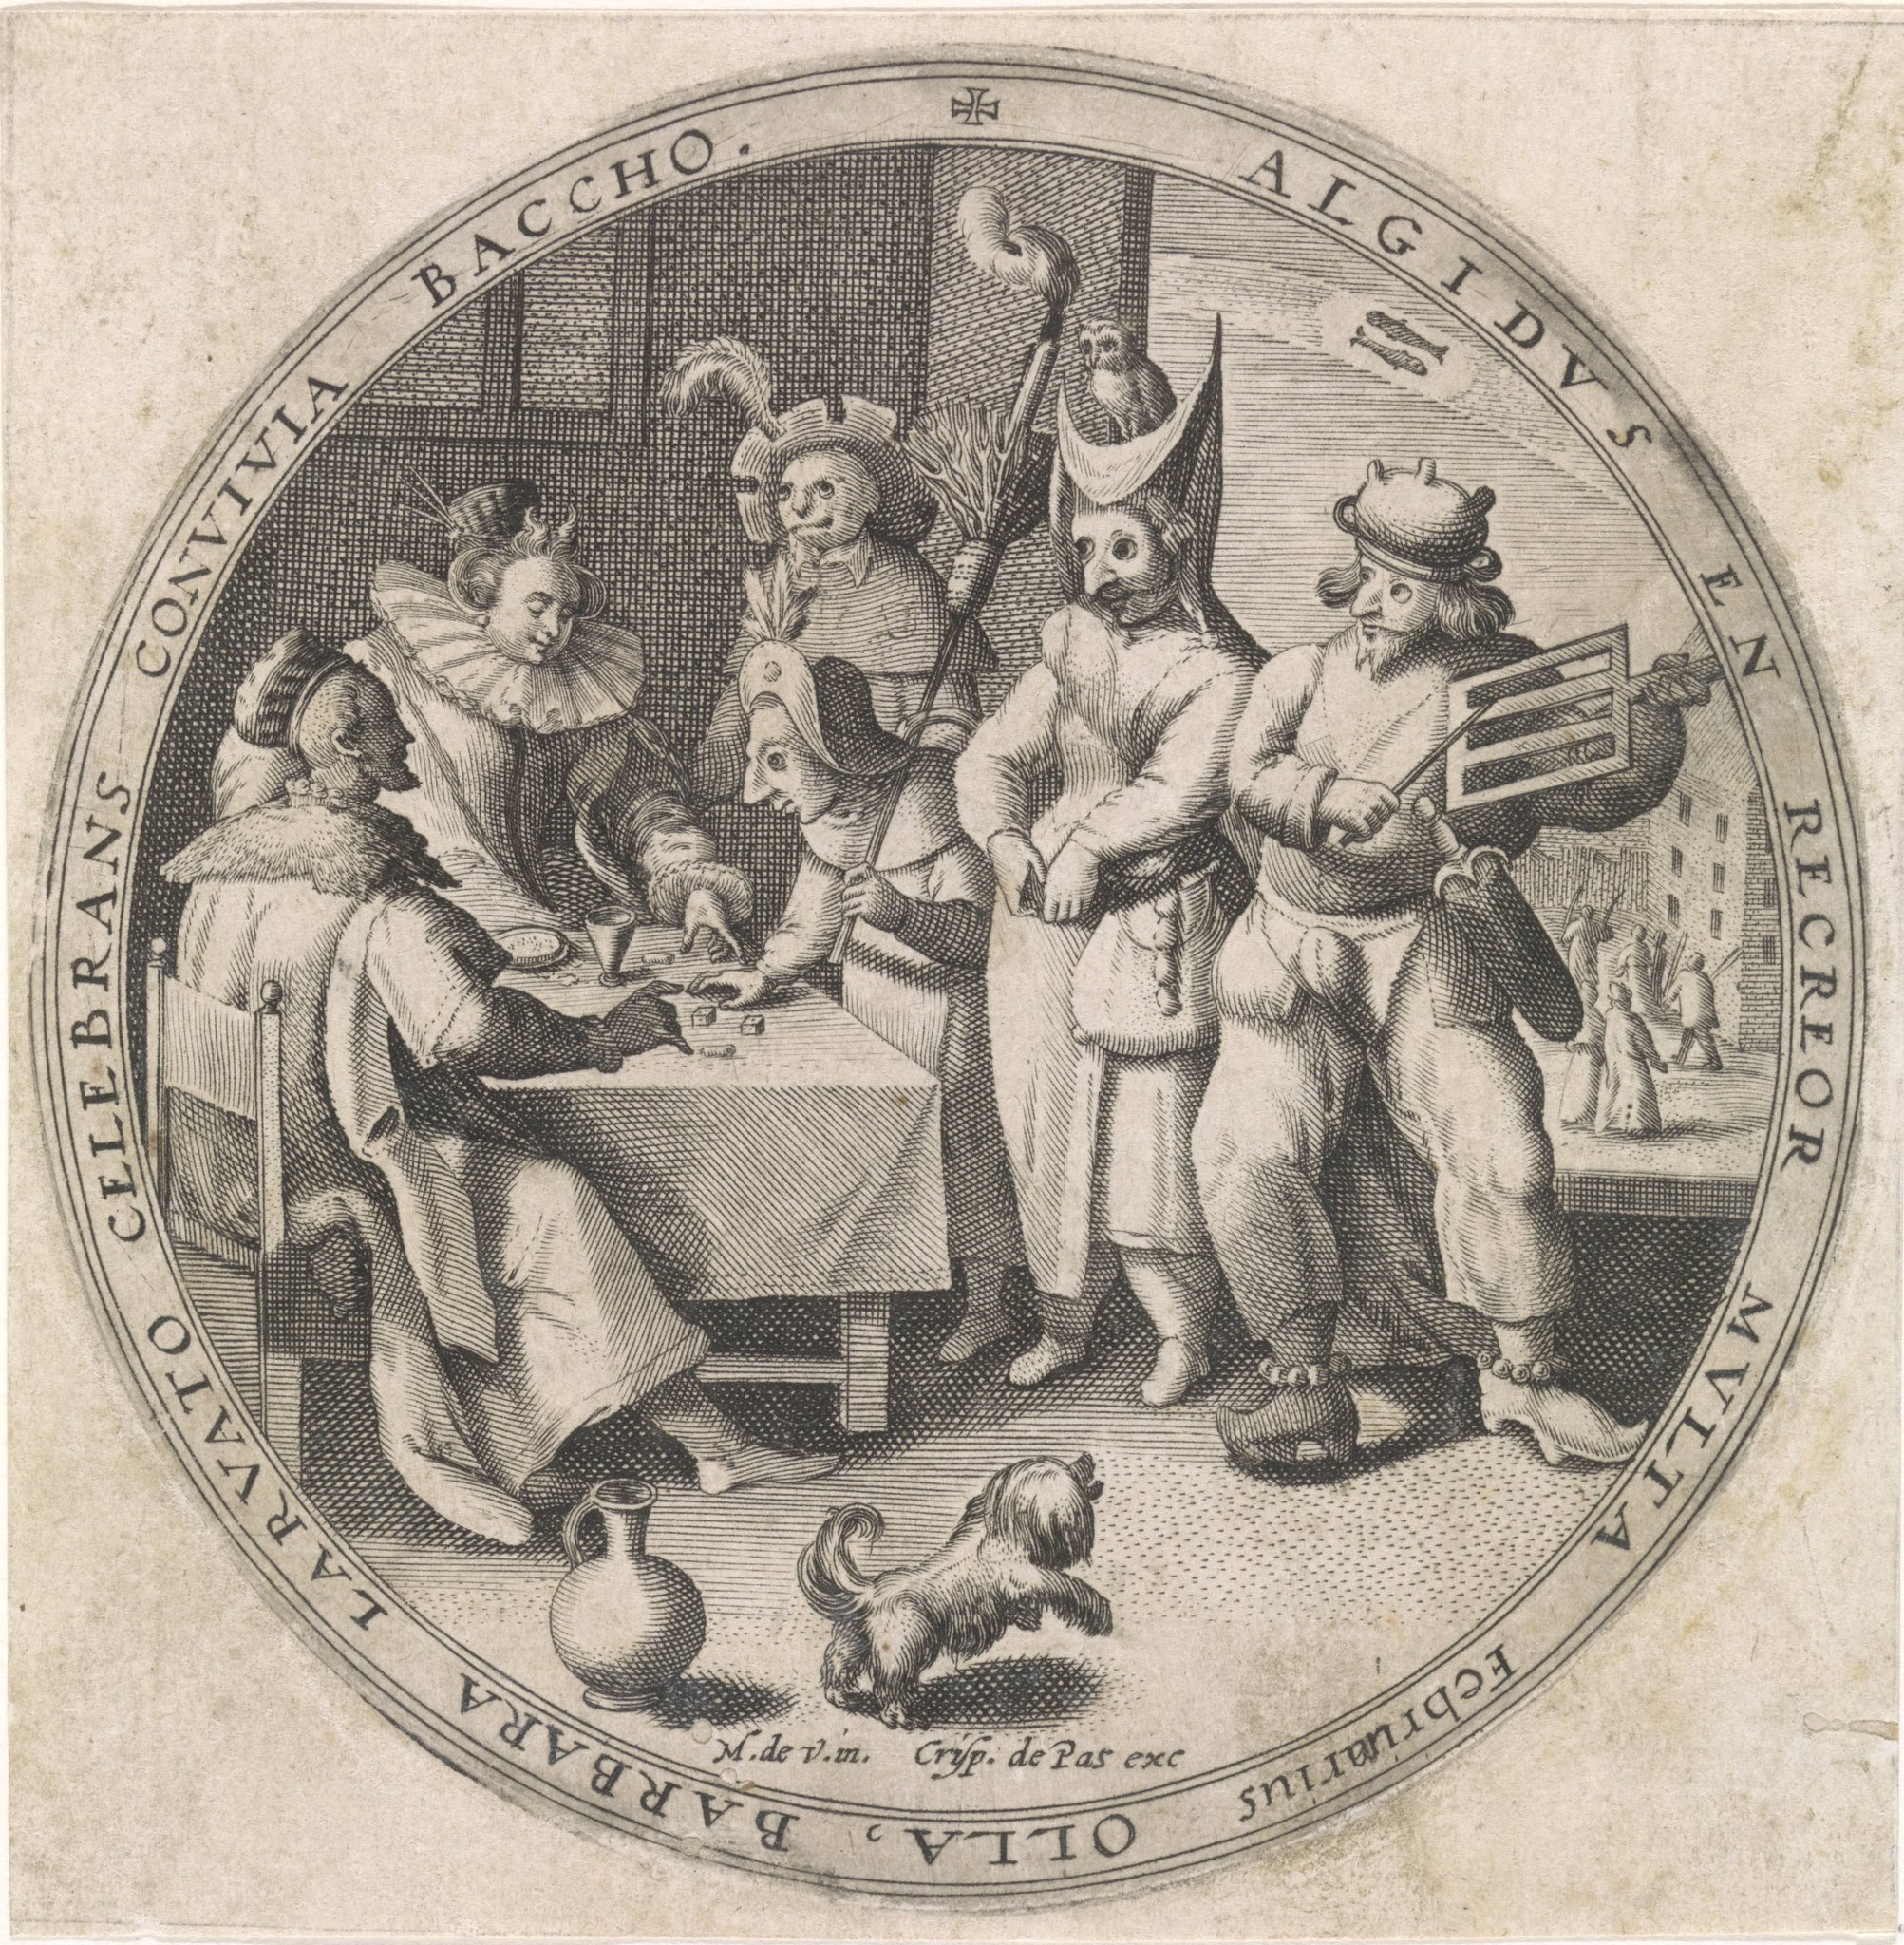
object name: print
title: Februari: Vastenavond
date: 1580-1588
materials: paper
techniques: engraving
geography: antwerp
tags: shrove tuesday, 'mardi gras' ~ non-liturgical celebrations of carnival, february and its 'labours' (+ with zodiacal signs)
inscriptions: collector's mark: Lugt 240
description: De maand februari: interieur met gemaskerde figuren en een dobbelend paar rond een tafel die Vastenavond vieren. Rechtsboven het teken van de dierenriem dat bij de maand februari hoort: Vissen. De prent heeft een omlijsting met een randschrift in het Latijn dat verwijst naar het feestvieren in de koude maand februari.